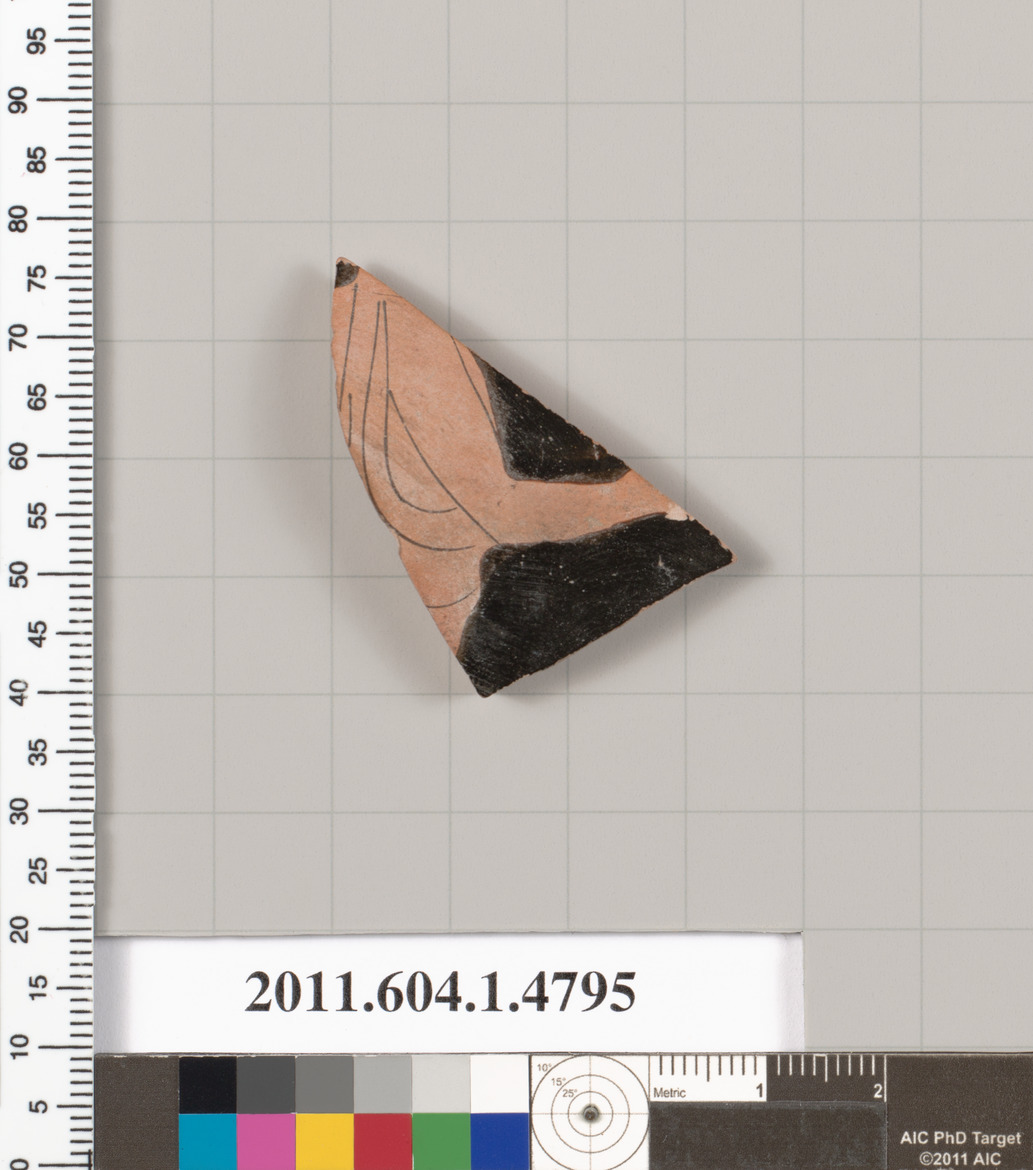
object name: kylix fragment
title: Terracotta fragment of a kylix (drinking cup)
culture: greek, attic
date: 475-451 BCE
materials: terracotta